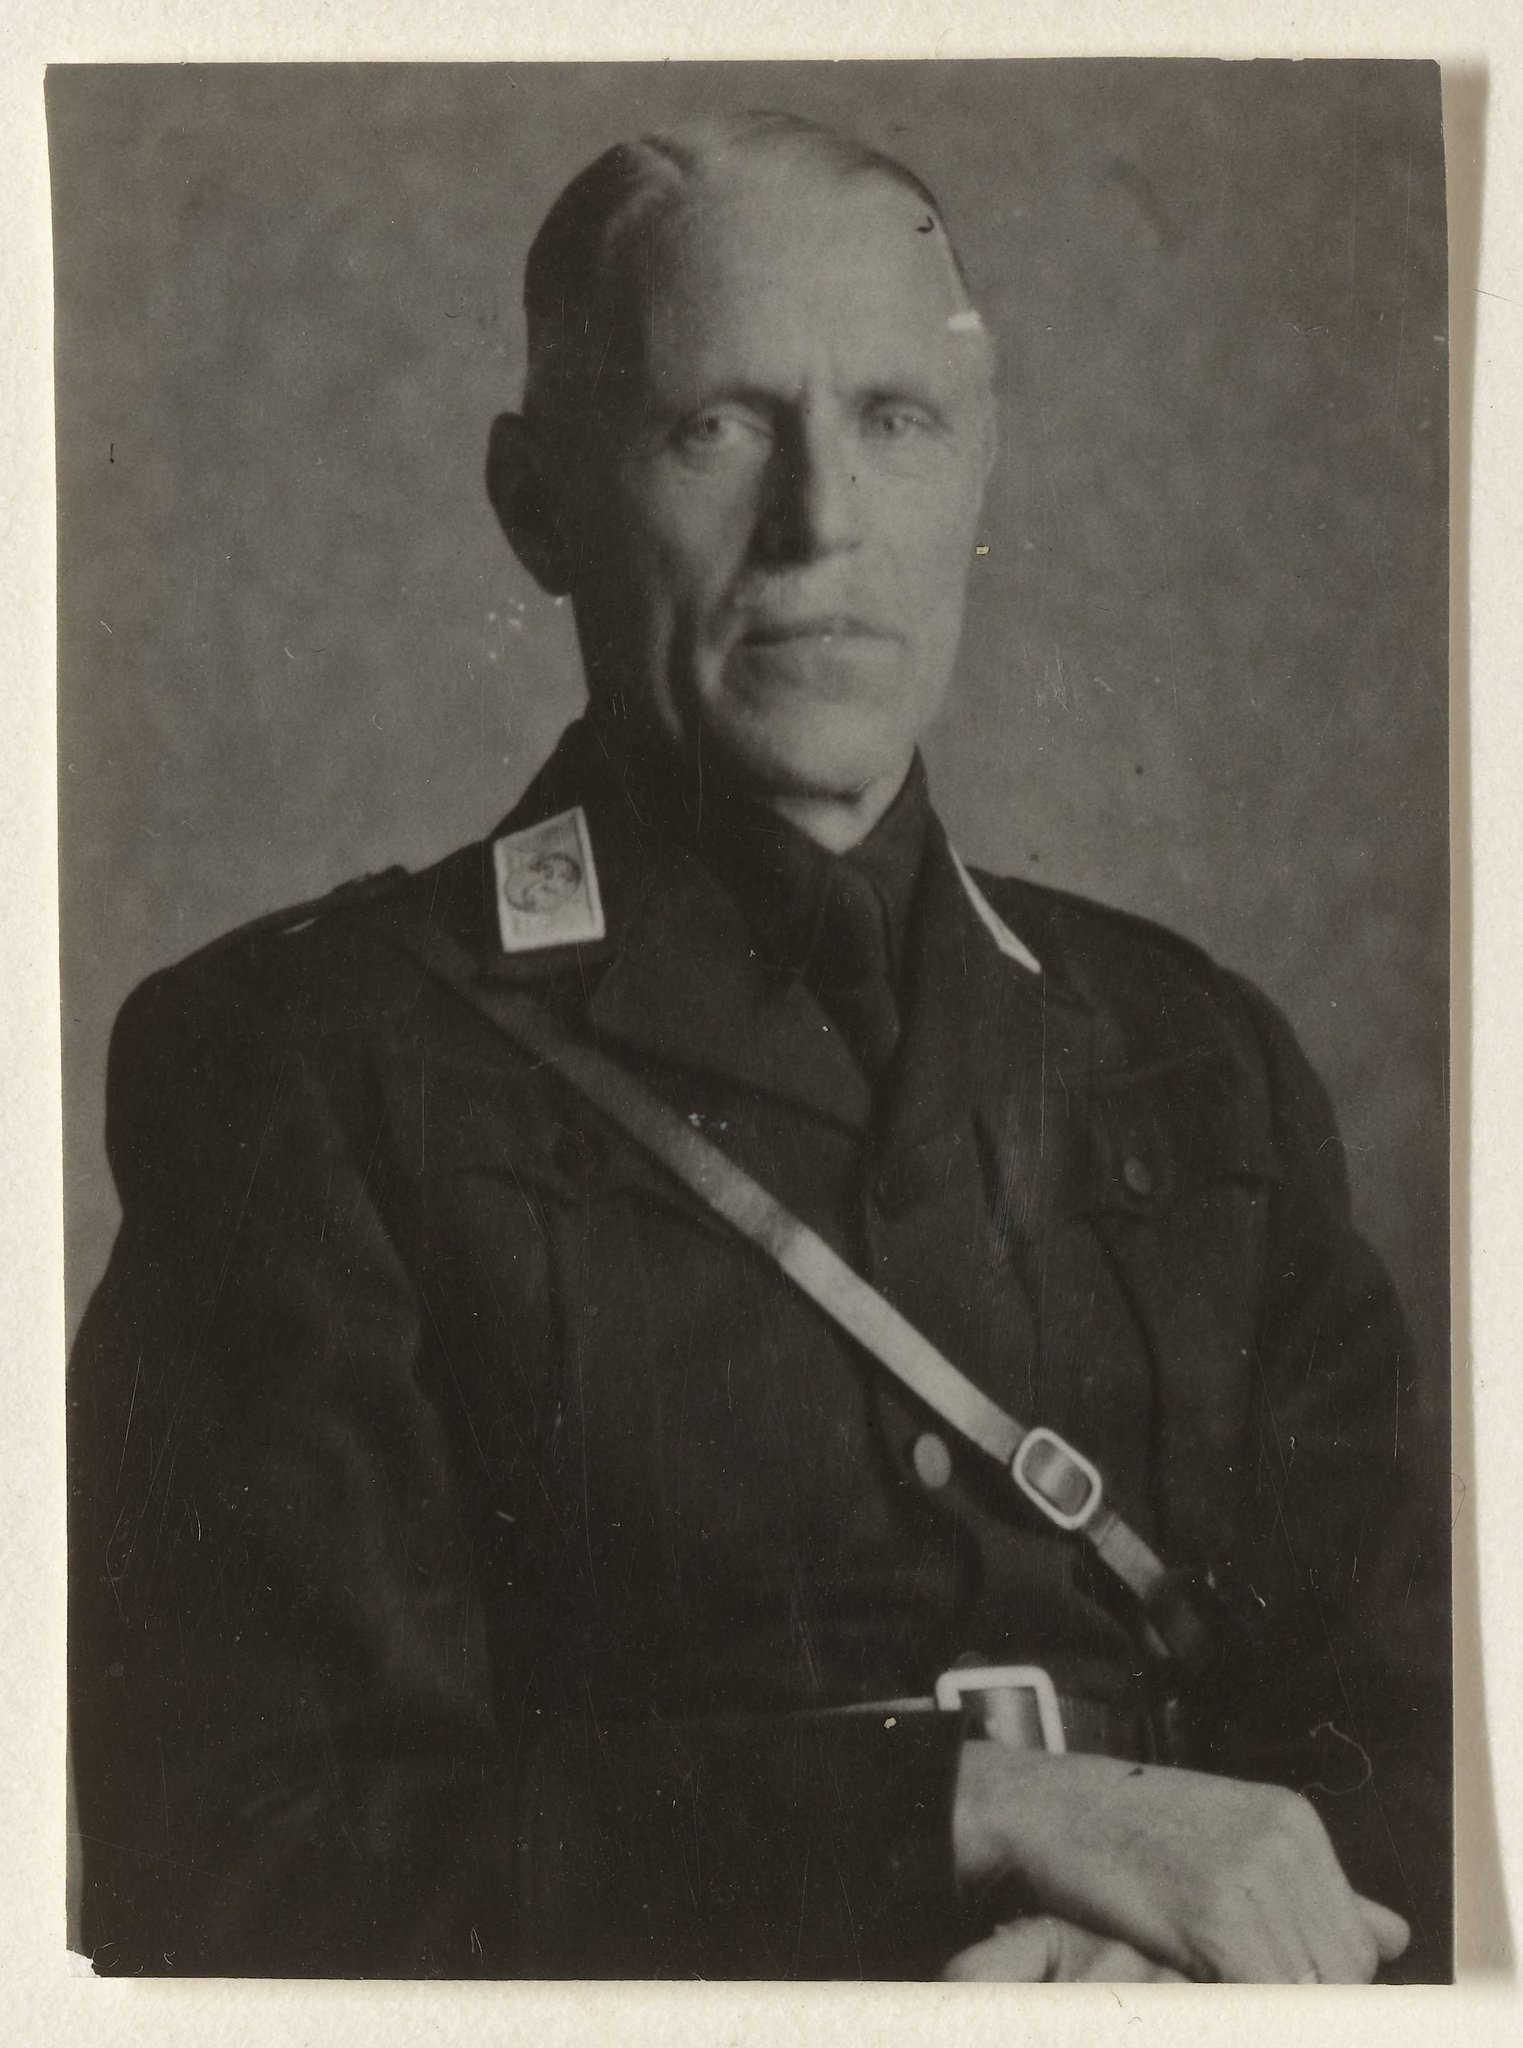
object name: contact print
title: NSB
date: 1940-1944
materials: photographic support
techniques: photography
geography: netherlands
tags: anonymous historical person portrayed, netherlands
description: Portret van een lid van de NSB. Op zijn kraag een distinctief dat lijkt op dat van het Nederlandsch Agrarisch Front. Het is een oudere man met snor, blootshoofds.